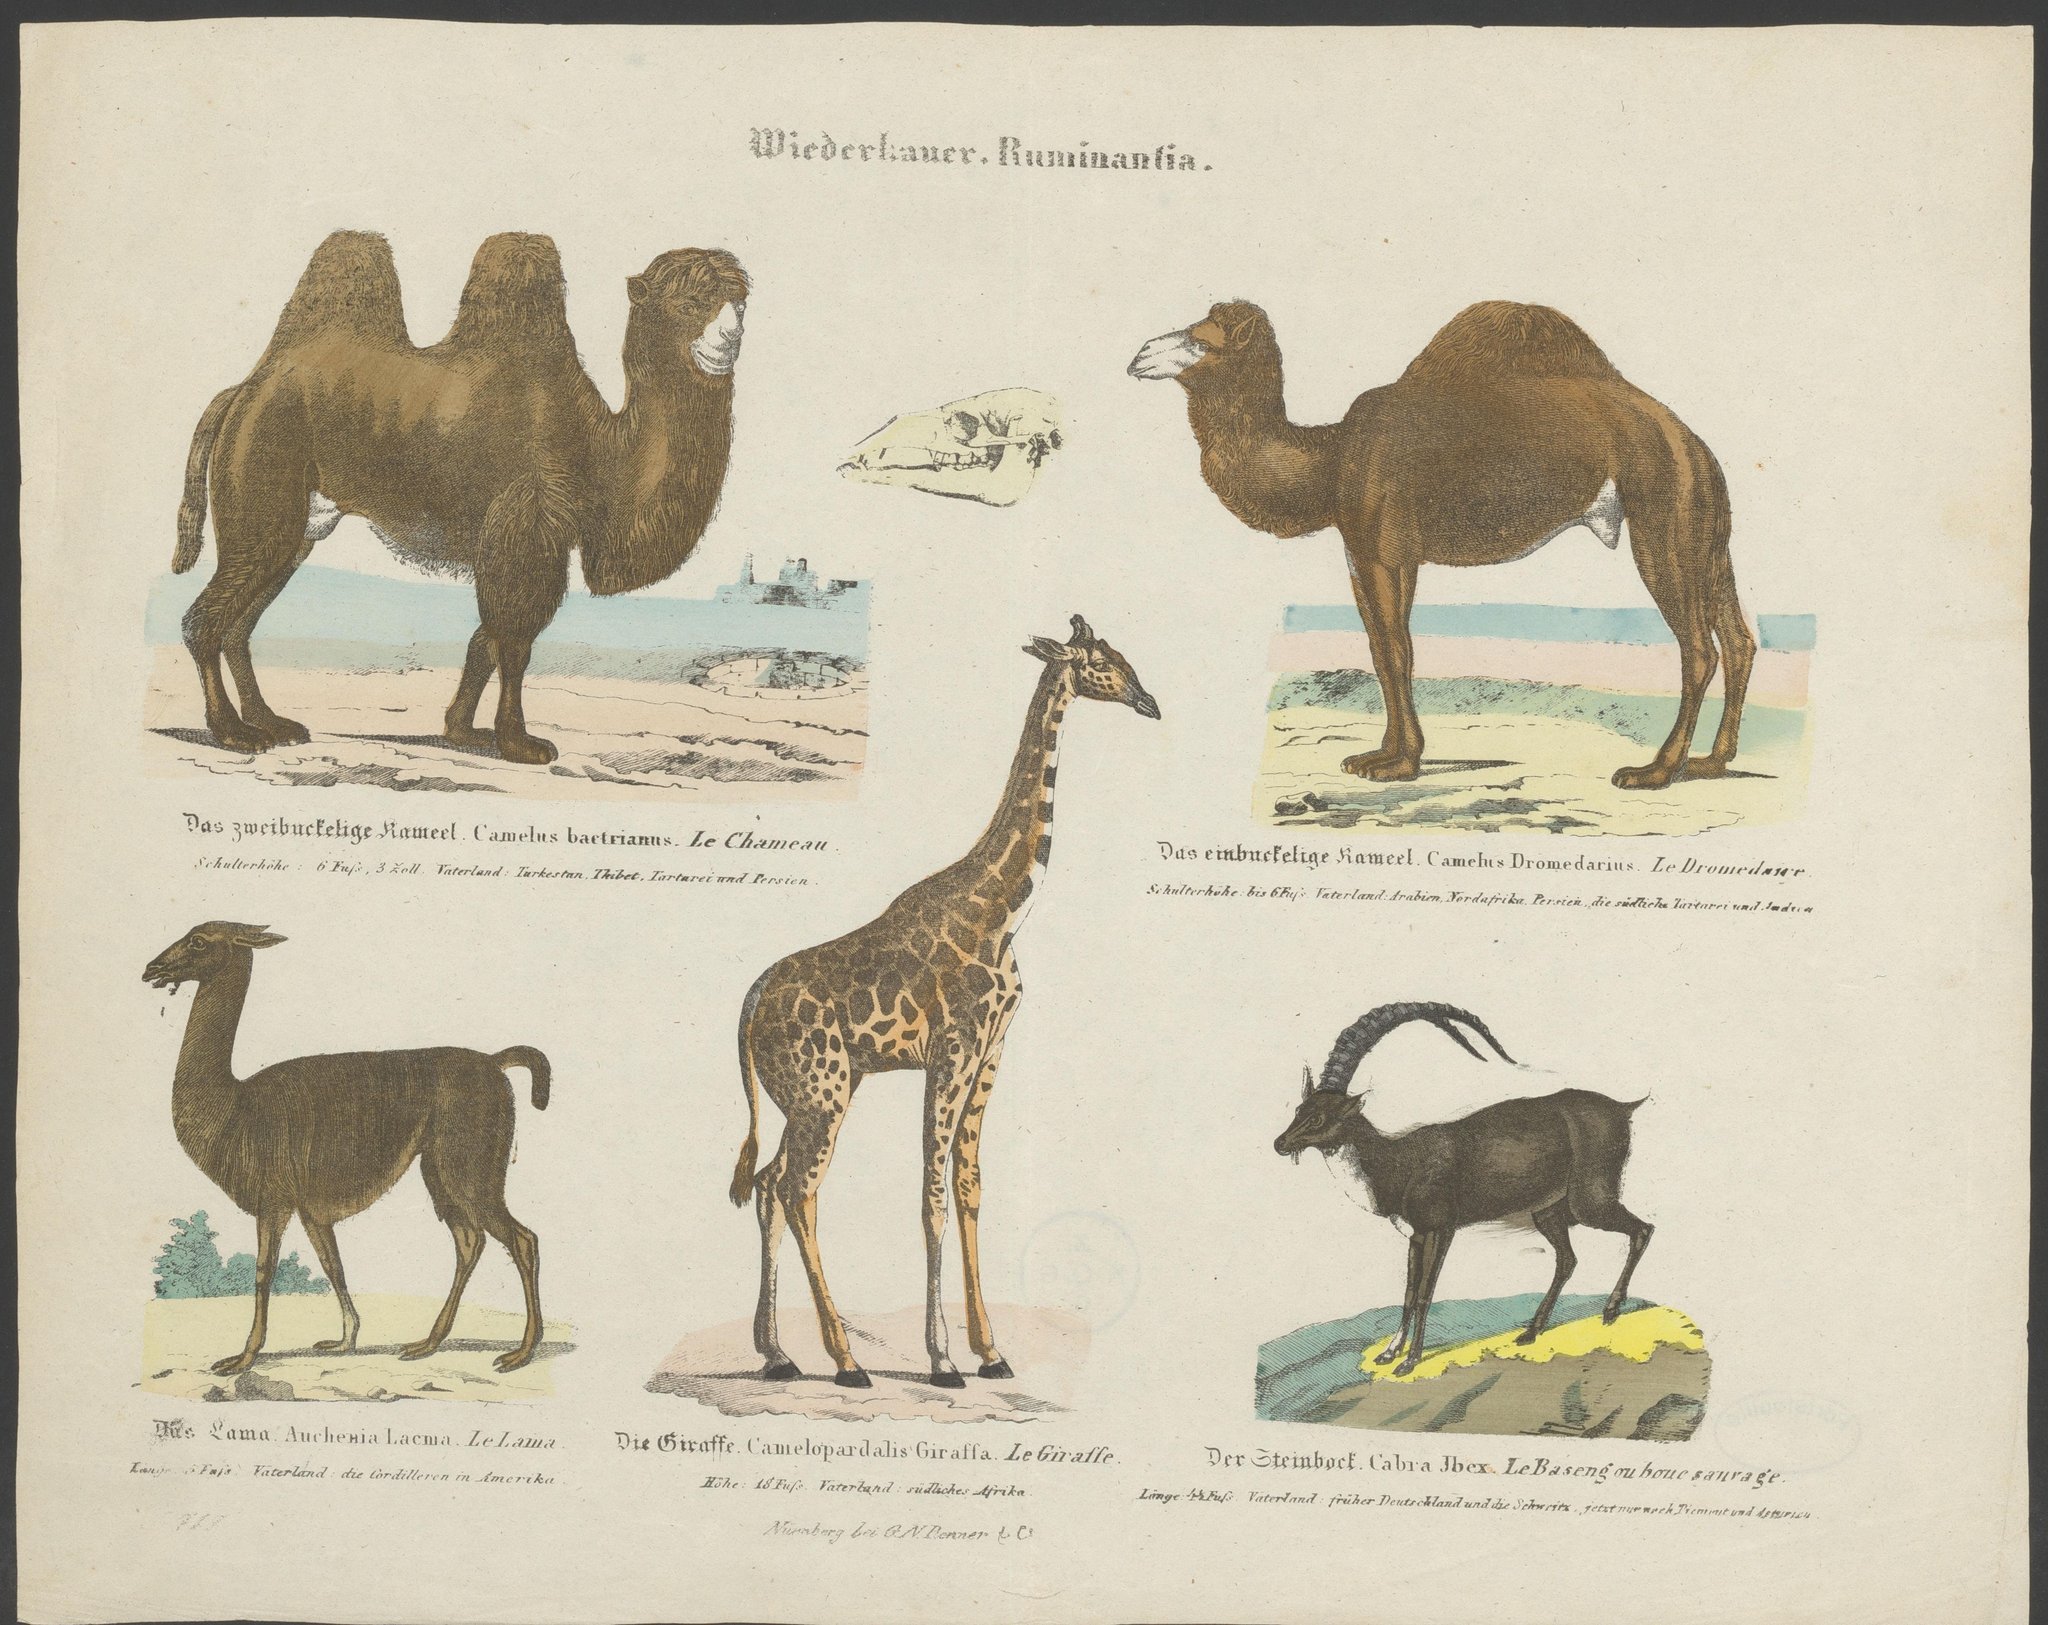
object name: print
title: Soorten herkauwers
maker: Anonymous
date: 1837-1868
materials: paper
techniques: hand coloring, lithograph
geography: nuremberg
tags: hoofed animals: camel, hoofed animals: dromedary, hoofed animals: giraffe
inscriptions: collector's mark: Lugt 1641, stamp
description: Vijf voorstellingen van diverse soorten herkauwers. In het midden een schedel van een herkauwer, omringd door een kameel, lama, giraf, steenbok en een dromedaris. Onder iedere voorstelling de naam van het soort in het Duits, Latijn en Frans. Daaronder de afmeting en land van herkomst van het dier. Onderwerpsrubrieken binnen de Atlas Zeden en Gewoonten: Zeden en Gewoonten in Engeren Zin, Des menschen beging, midden en einde, Kinderleven – Kinderspel en Kinderprenten.